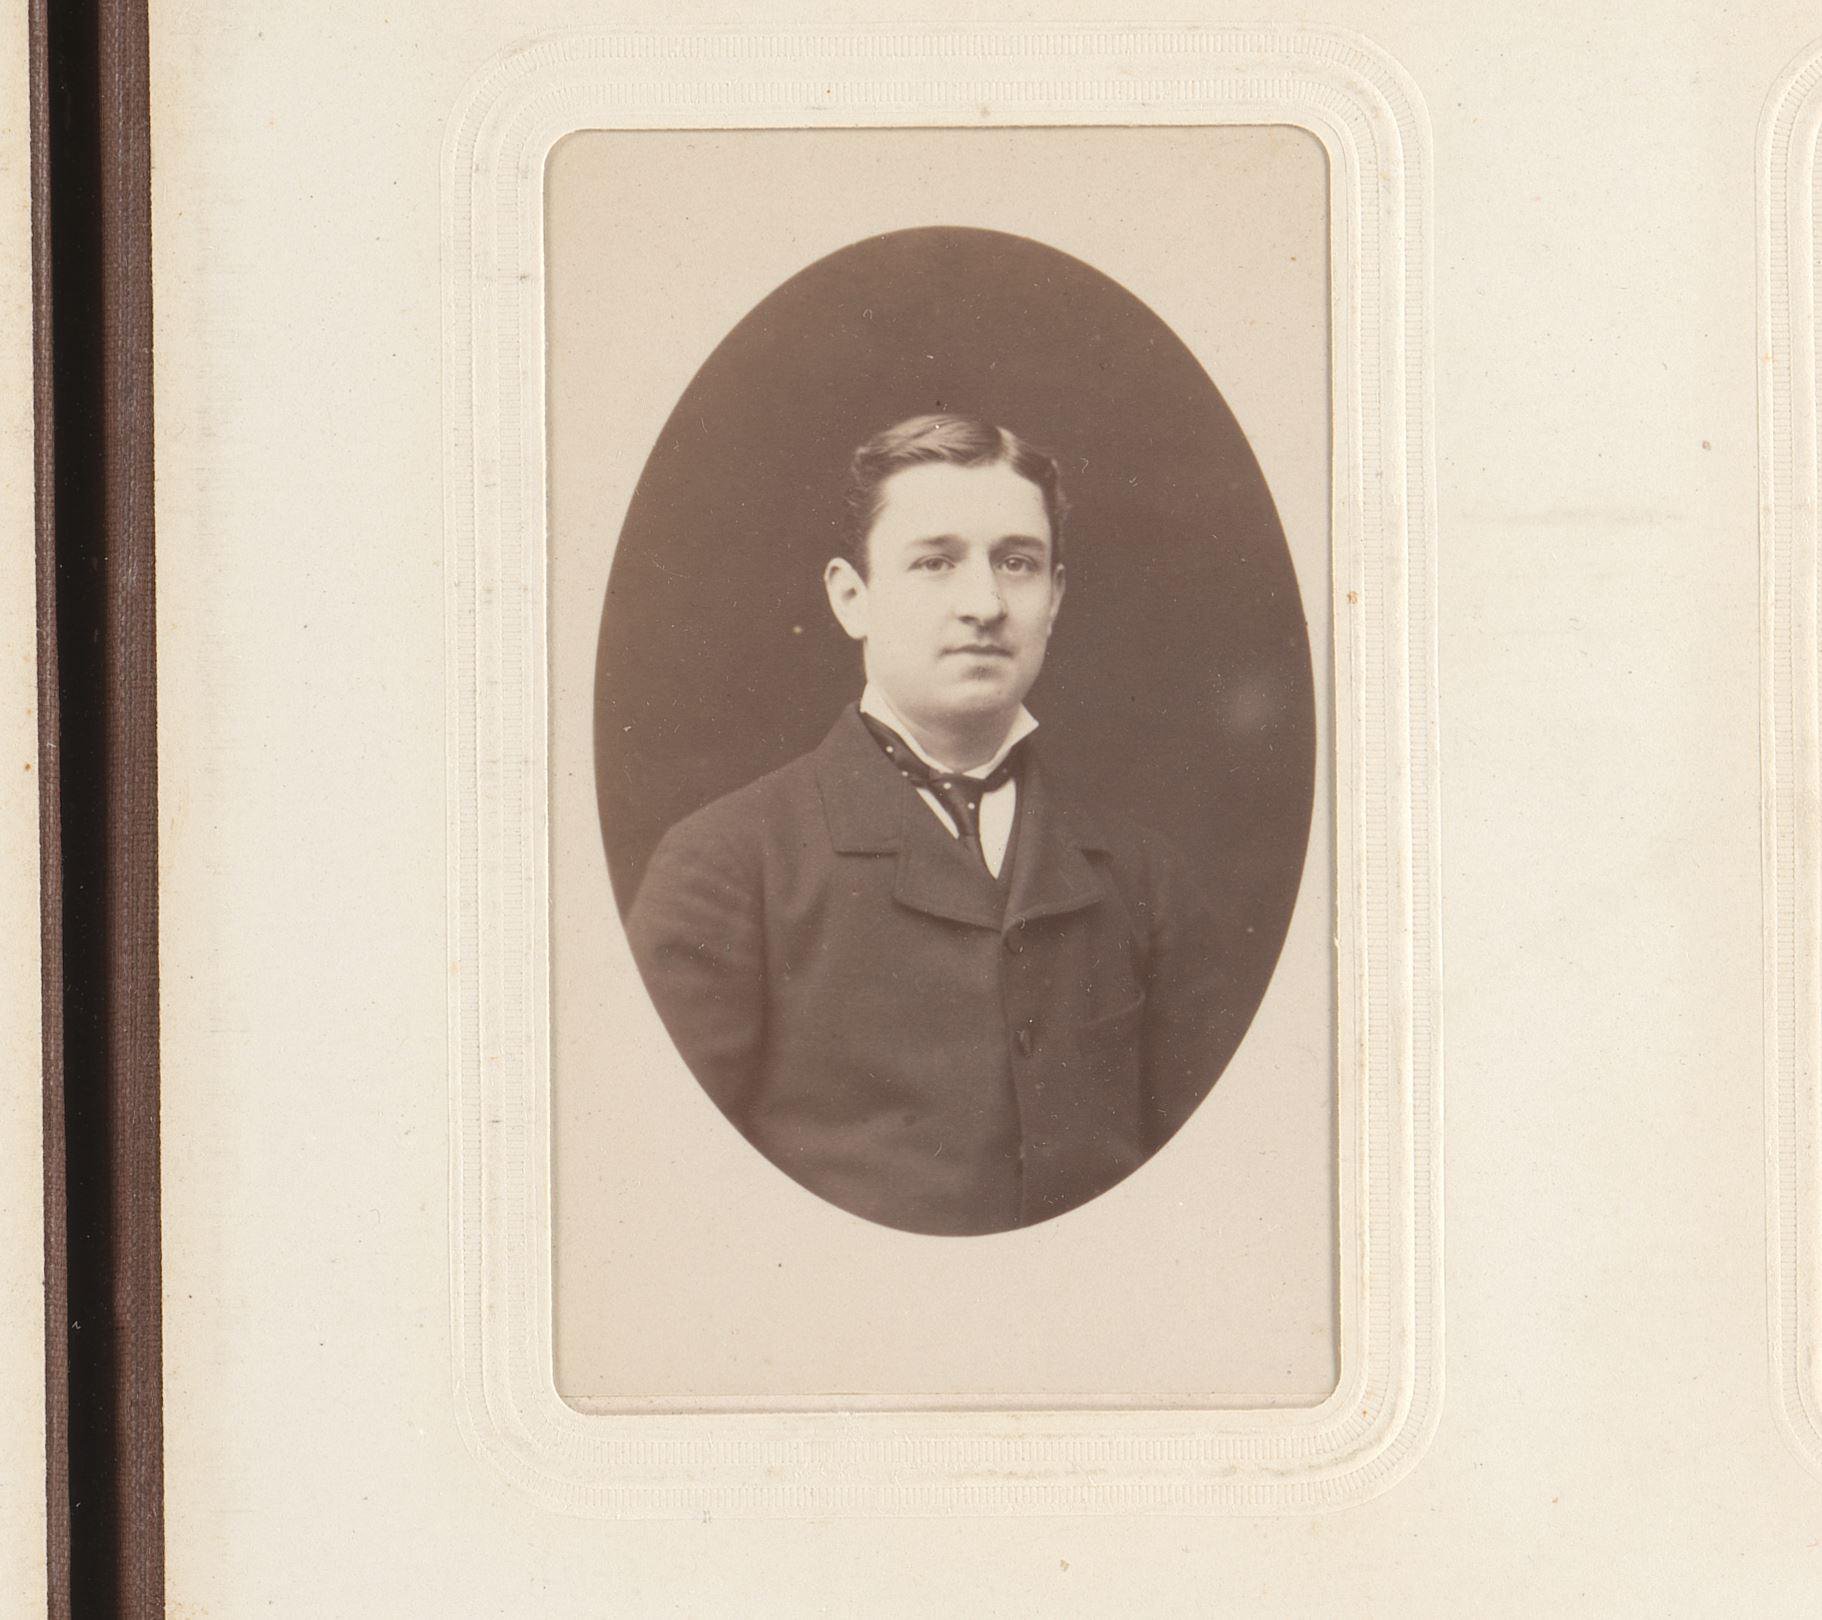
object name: carte de visite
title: Portret van een man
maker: Anonymous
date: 1865-1900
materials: cardboard, paper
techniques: albumen print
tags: adult man, historical persons